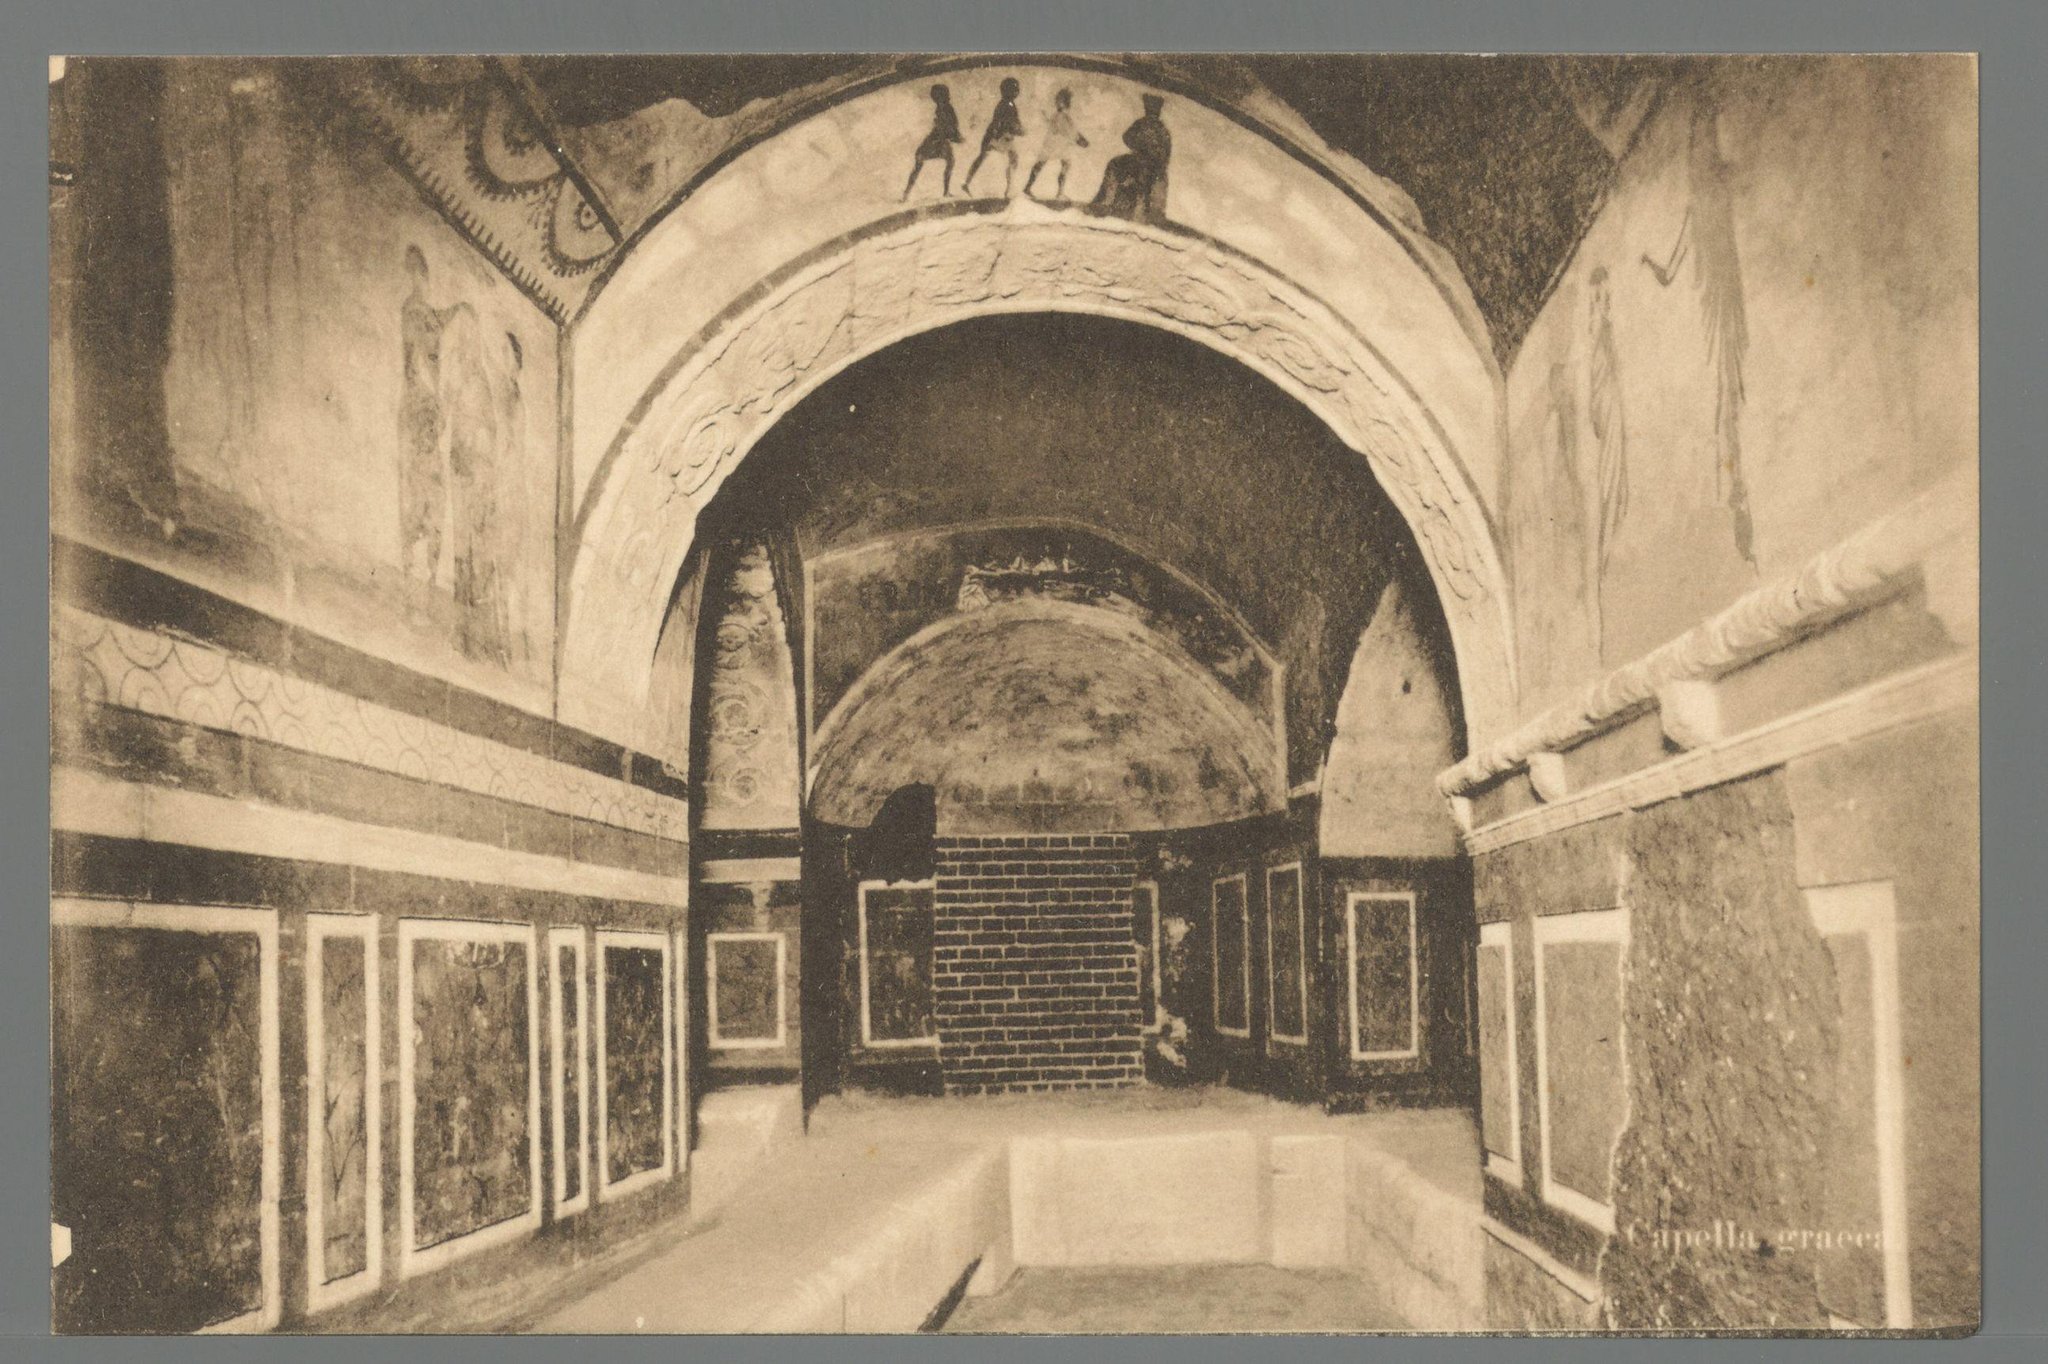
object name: ansichtkaart, prentbriefkaart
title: Romeinsche Katakomben, Valkenburg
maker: Anonymous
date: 1905-1927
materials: cardboard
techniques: photograph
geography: valkenburg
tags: interior ~ representation of a building, catacombs